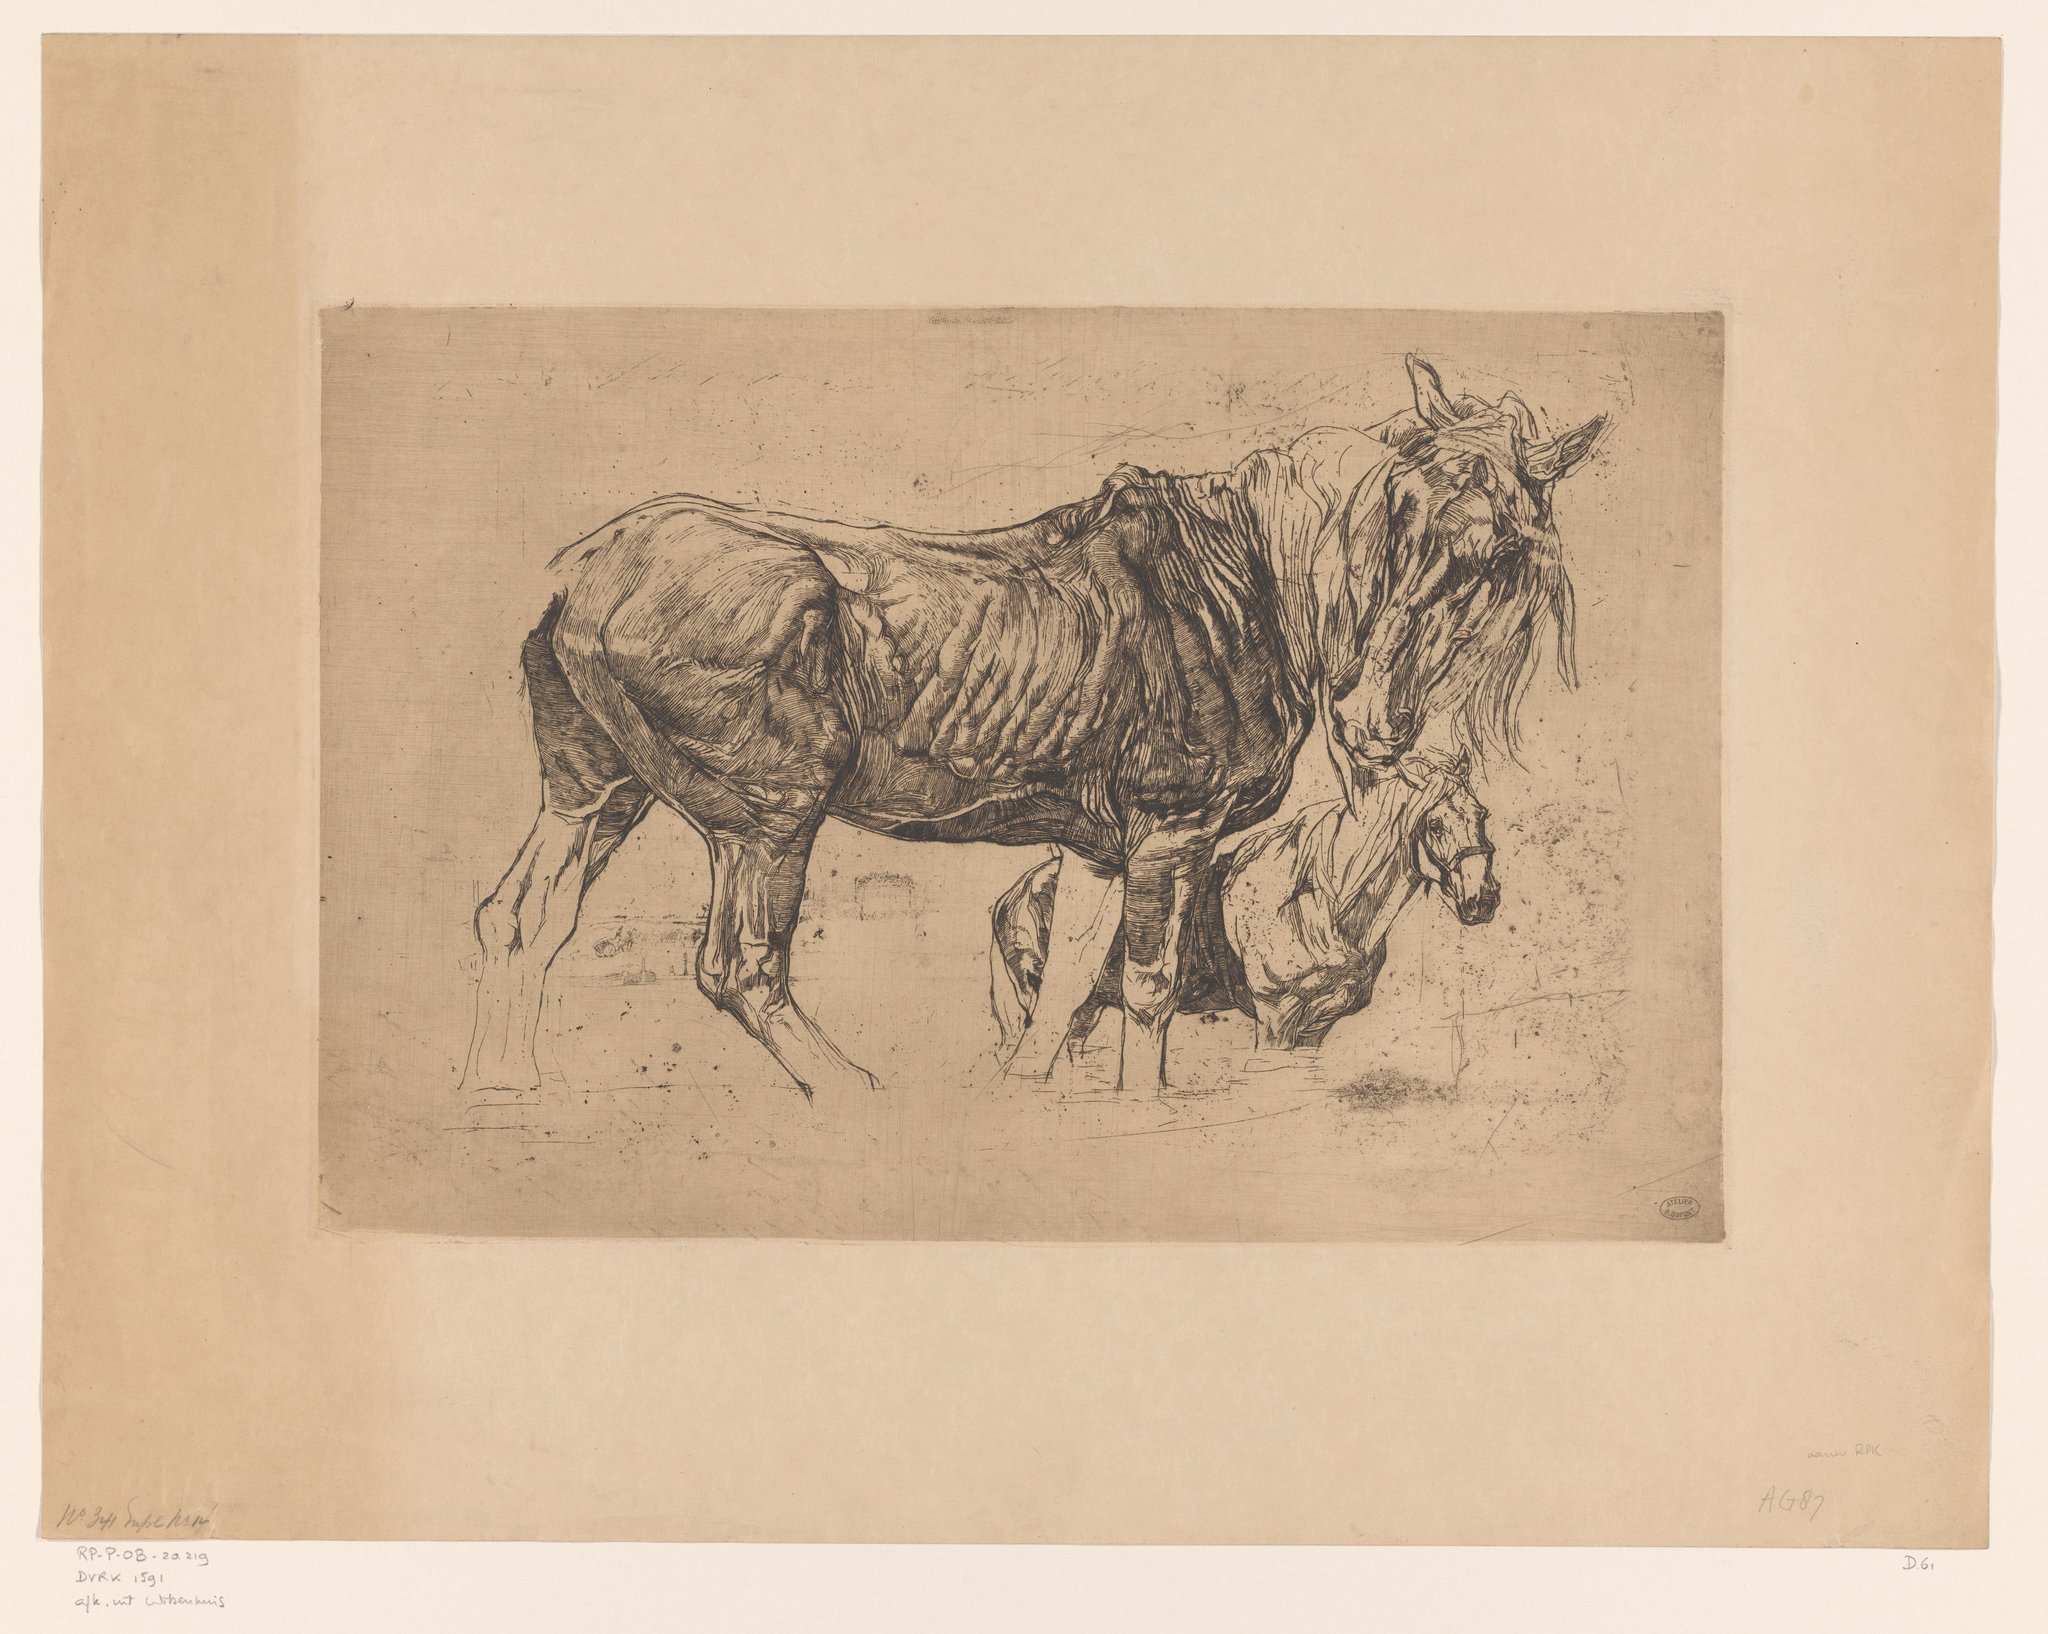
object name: print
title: Twee paarden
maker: pieter dupont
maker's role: draughtsman, print maker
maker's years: 1870-1911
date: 1897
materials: paper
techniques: etching, intaglio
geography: amsterdam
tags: horse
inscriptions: inscription: ‘No. 341 [...] No. 14’, collector's mark: Lugt 705a